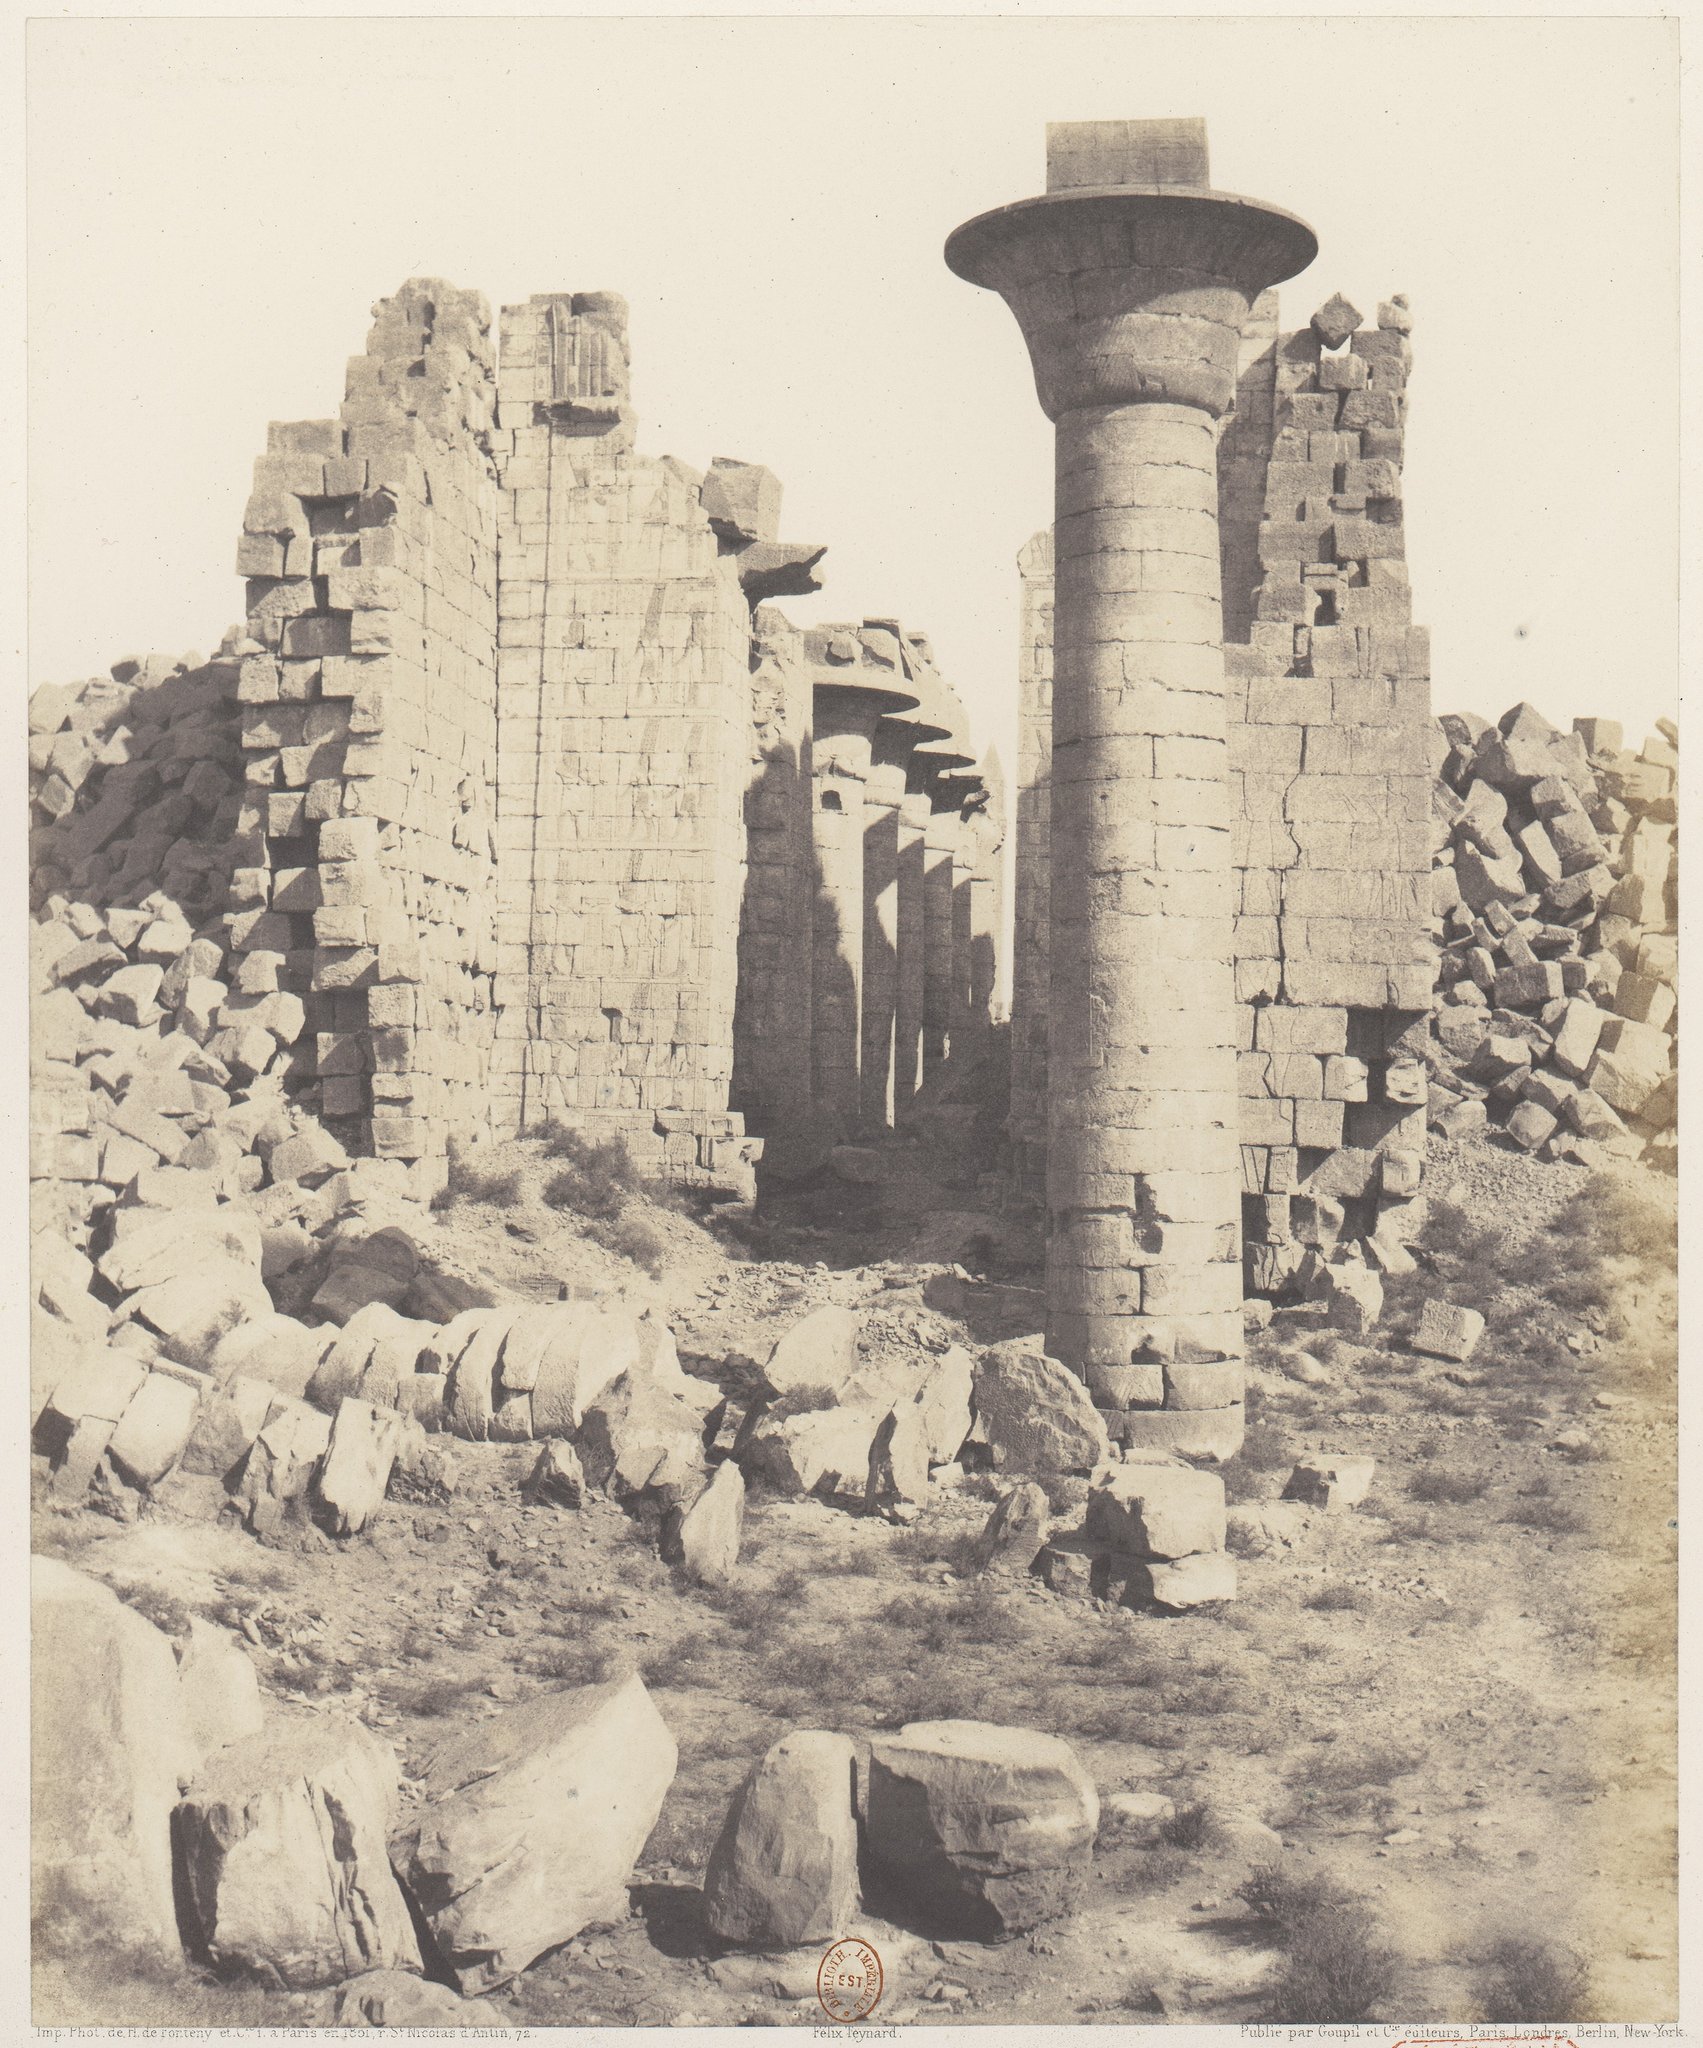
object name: photograph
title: Karnak (Thèbes), Cour du Palais - Vue Prise de Point I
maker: félix teynard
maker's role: artist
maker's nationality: french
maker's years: 1817-1892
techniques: paper negative, salted paper print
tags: architecture,ruins